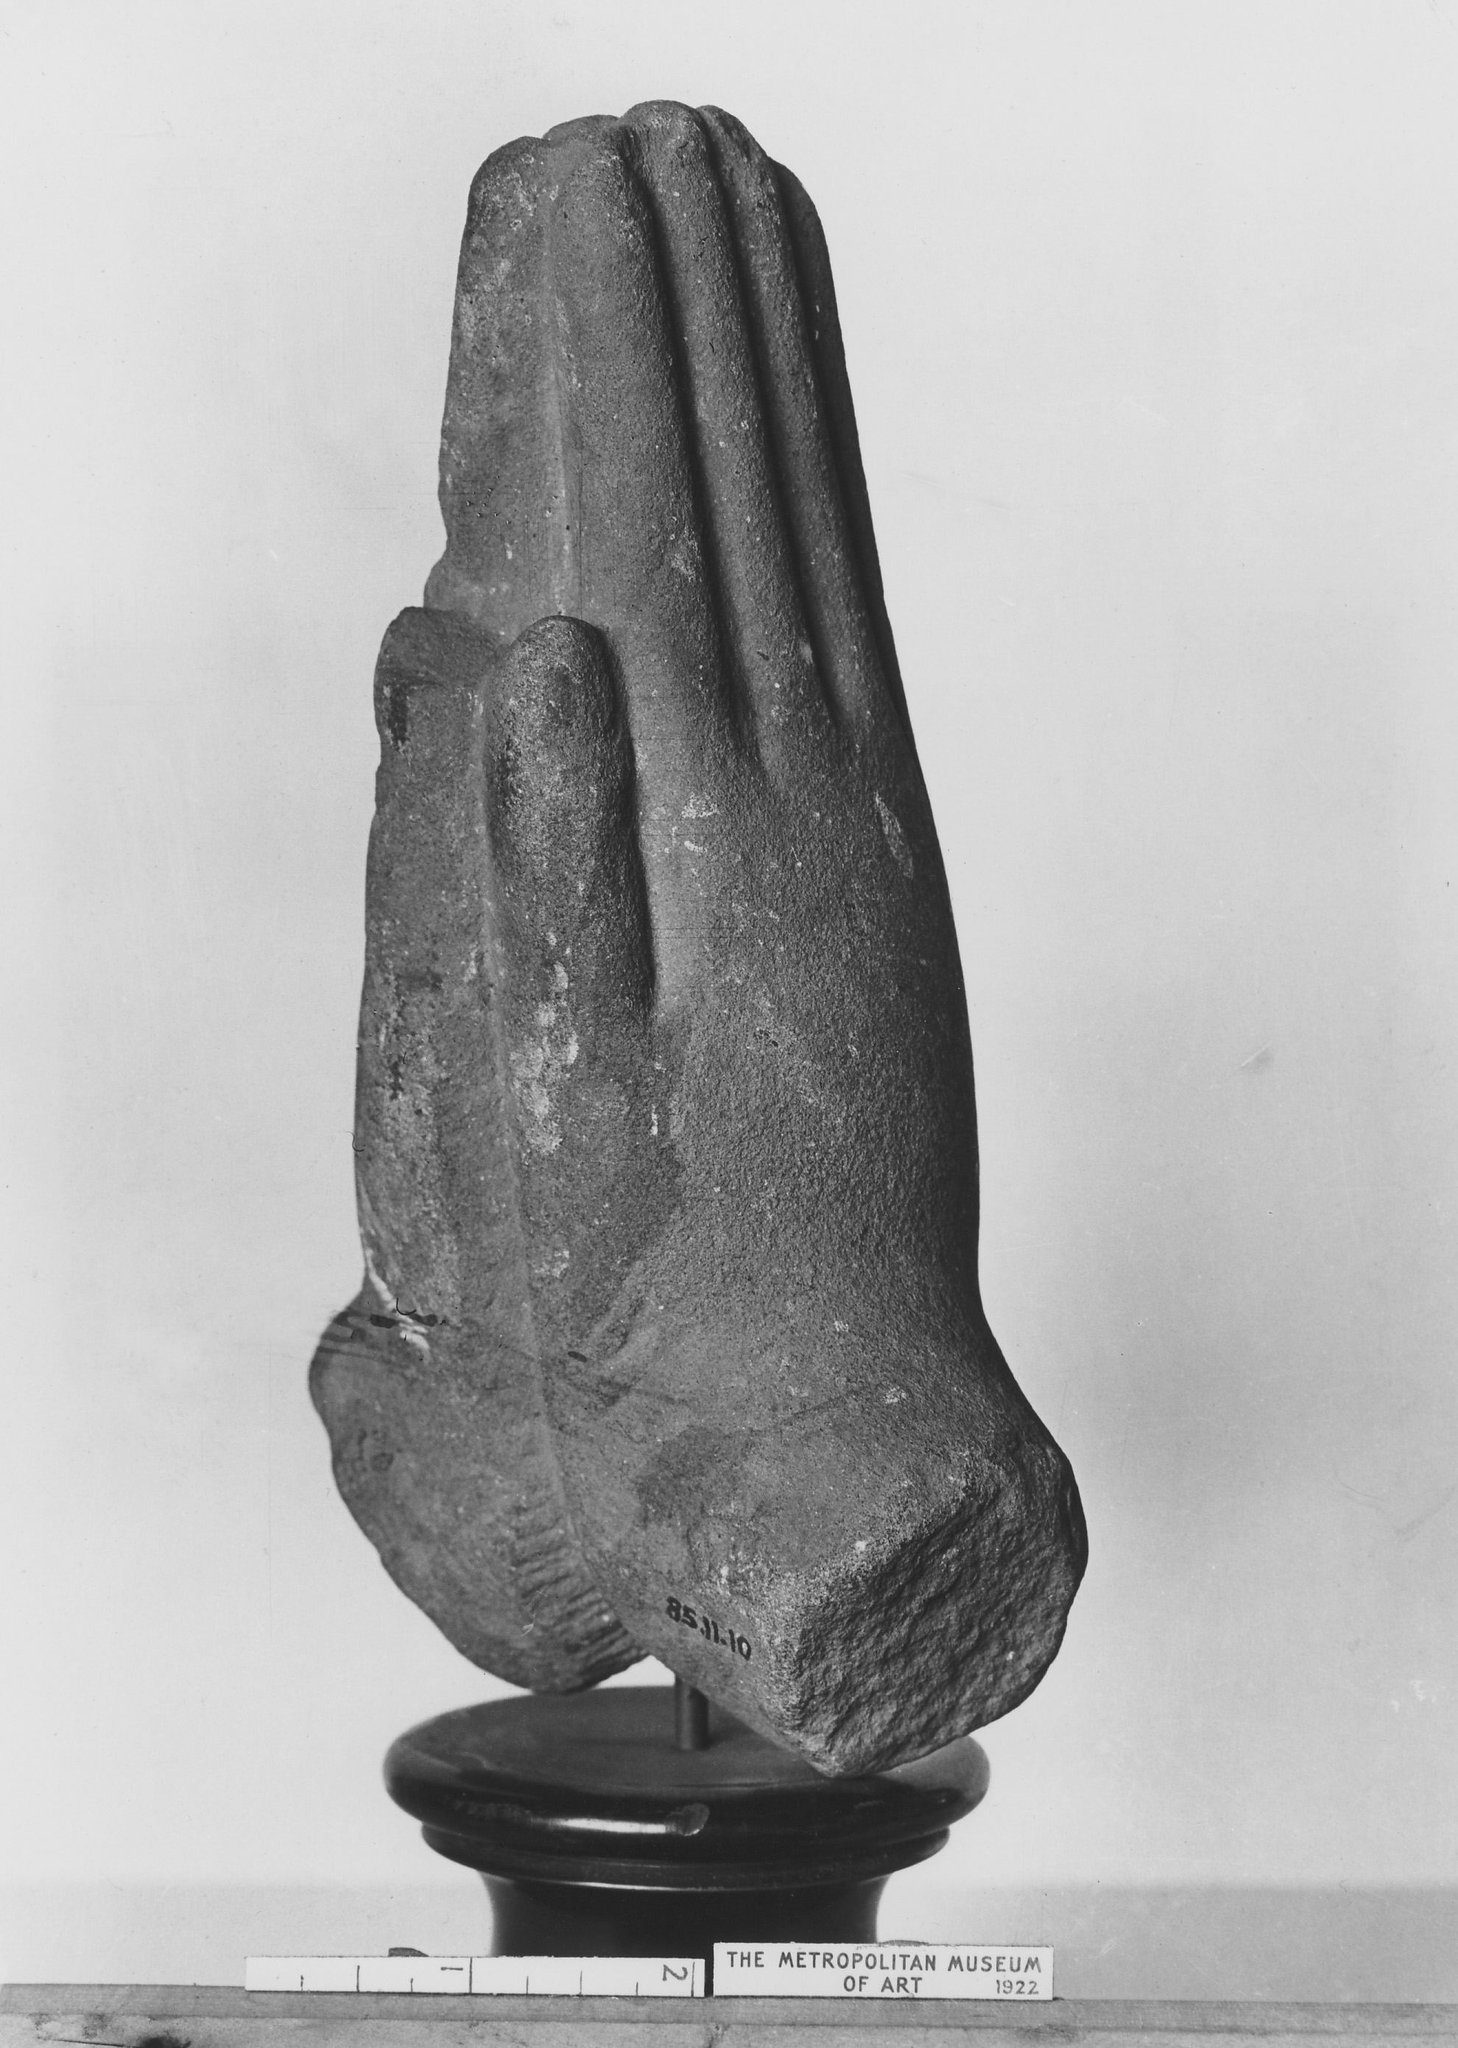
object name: hand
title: Hands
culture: cambodian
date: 901-1000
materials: stone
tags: hands